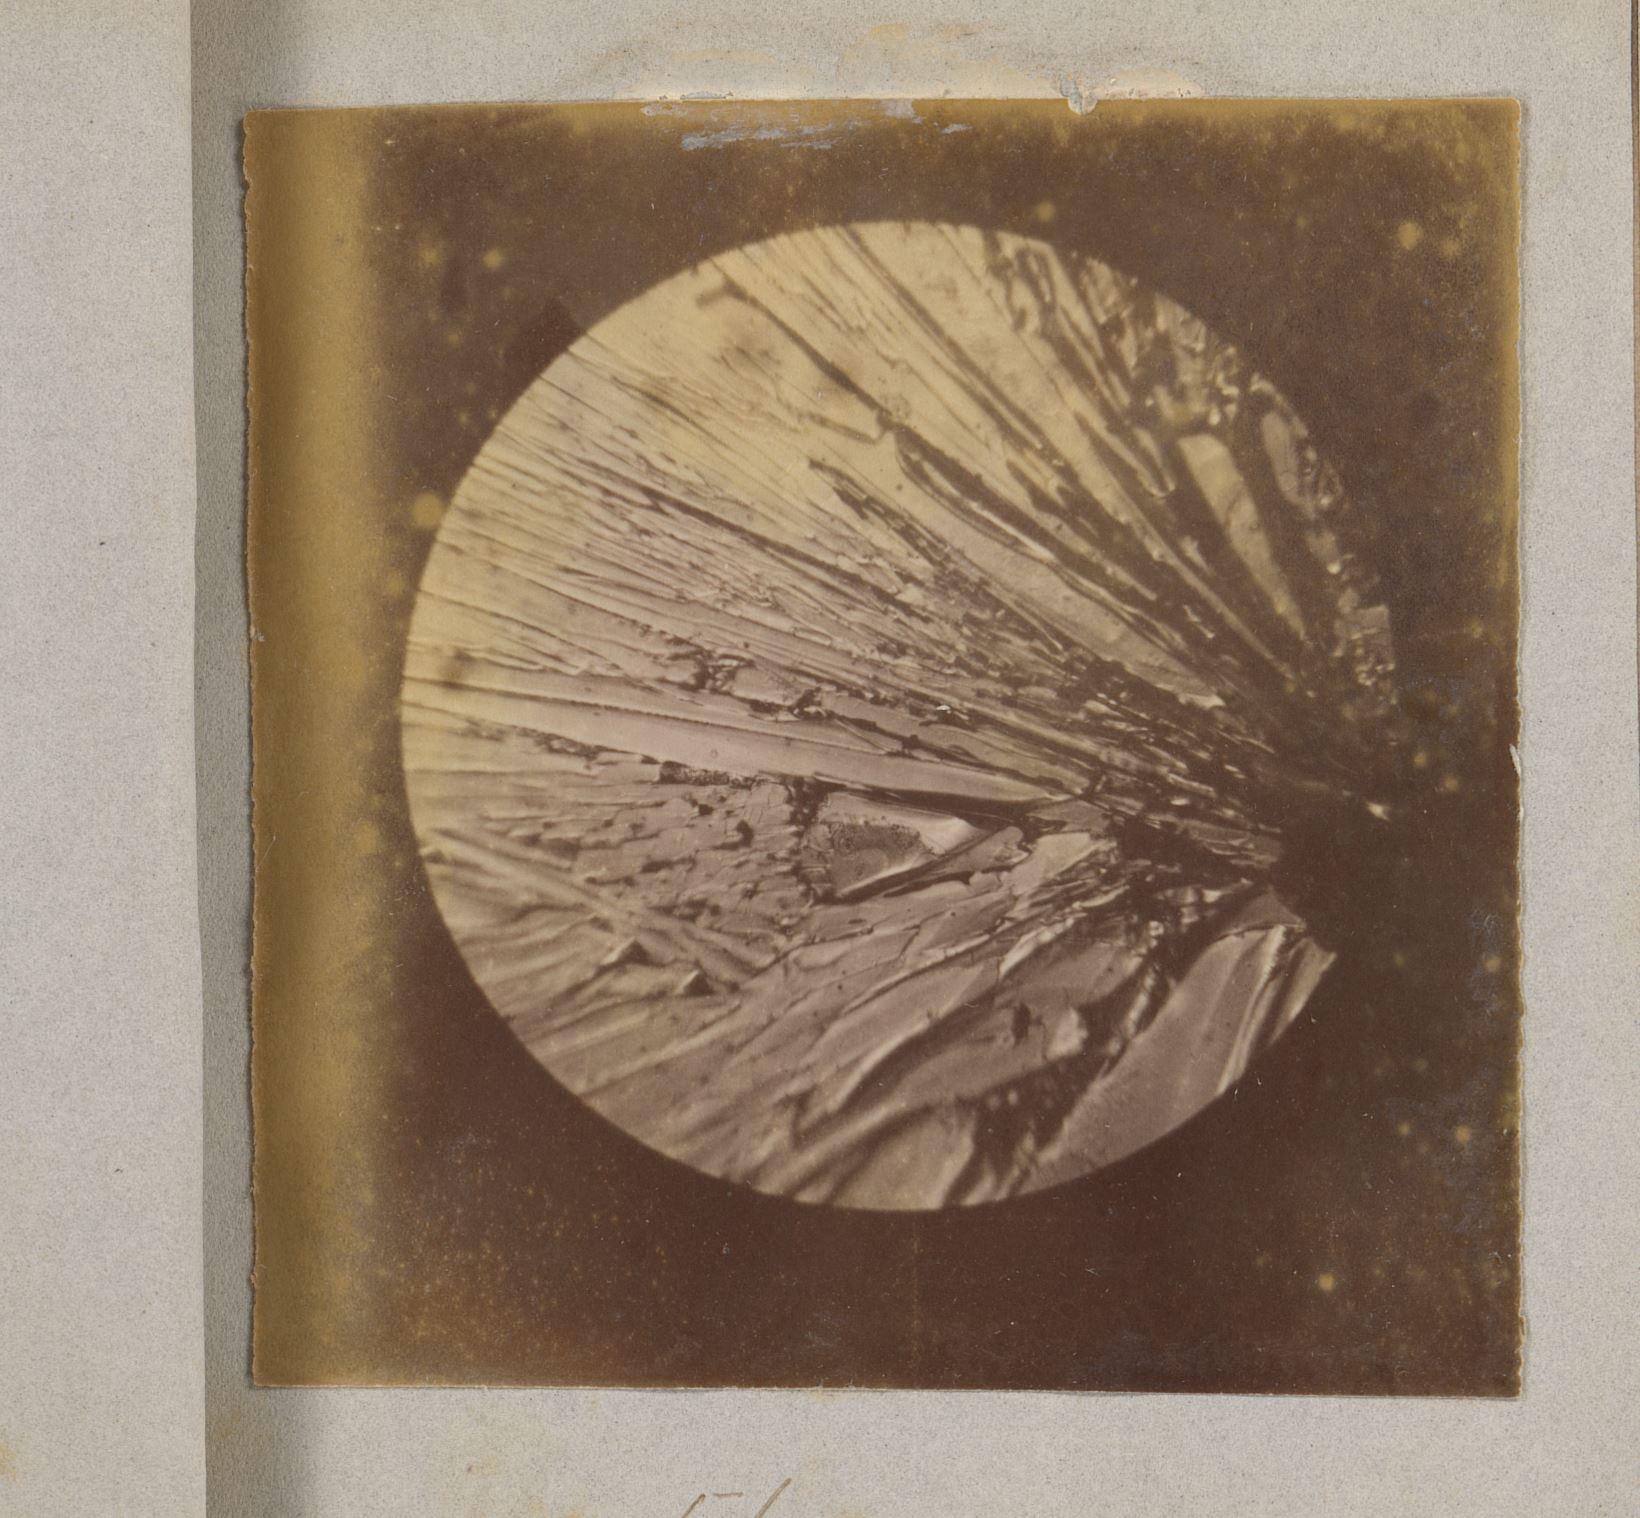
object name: photograph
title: Microscopische opname van zwavelzuurmangaan, zestig keer vergroot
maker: marinus pieter filbri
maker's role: instrument maker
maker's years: 1852-1917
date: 1887-1888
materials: paper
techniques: albumen print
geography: netherlands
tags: chemical substances, netherlands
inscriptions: number: ‘56’, inscription: ‘No. 56. Benaming Zwavelzure mangaan, vergroting 60x, pose 6 min, bemerking Lomb.’